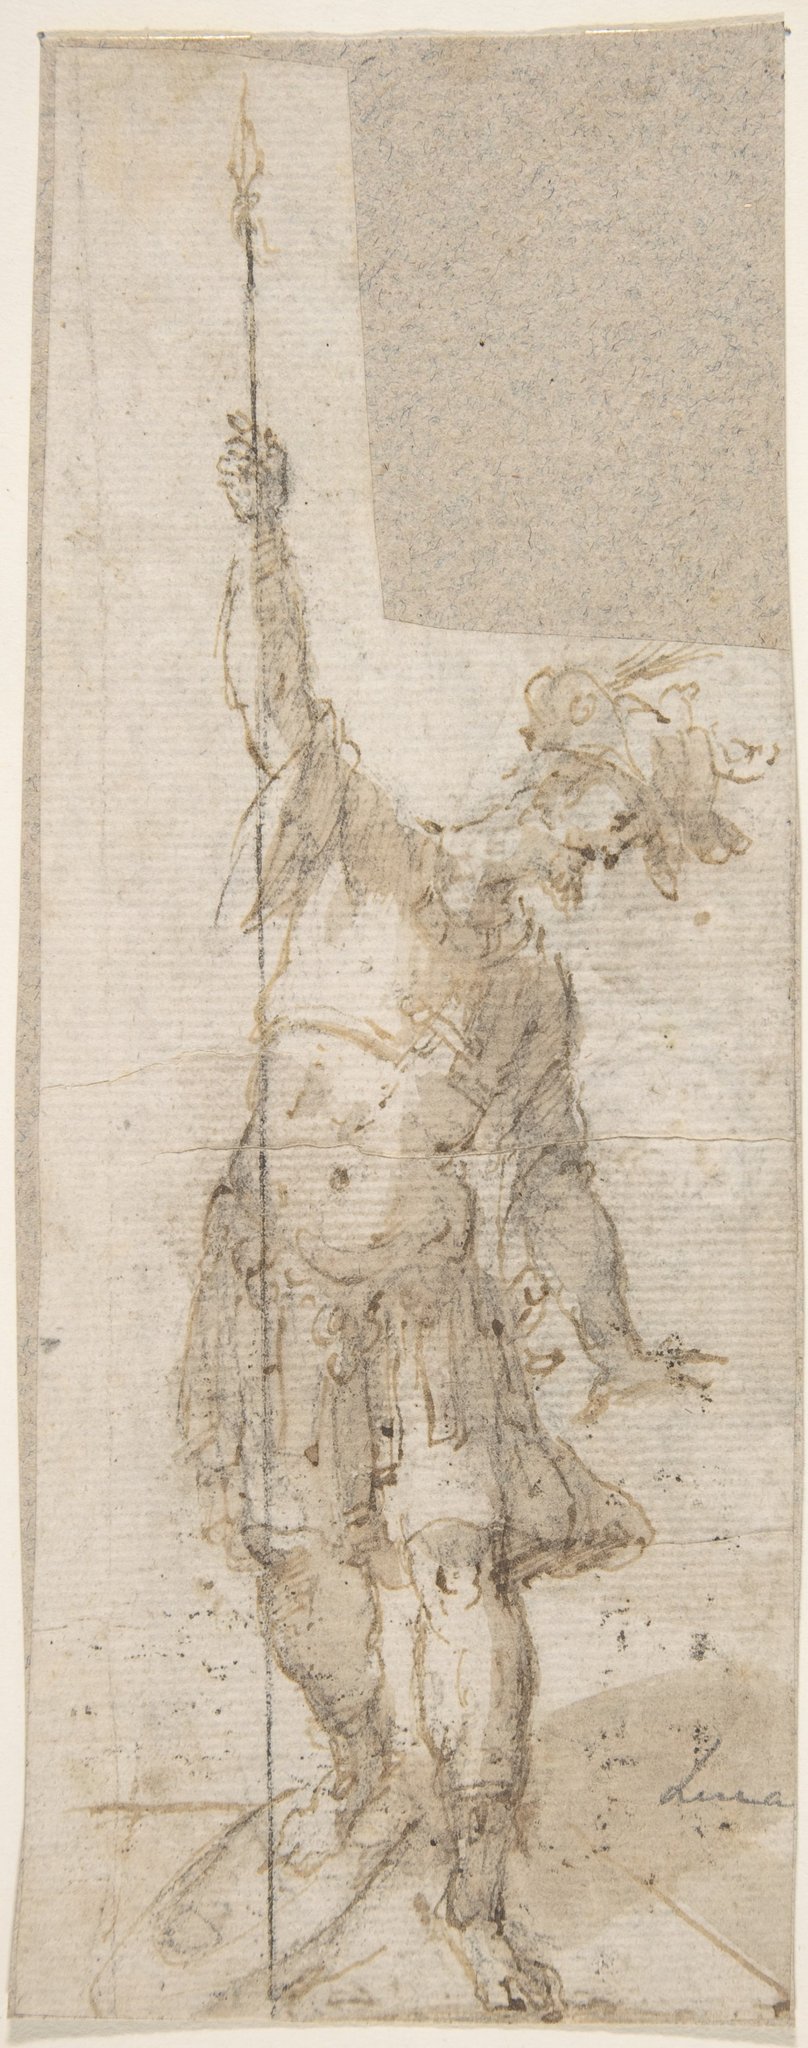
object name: drawing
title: Standing Soldier with a Spear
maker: anonymous, spanish, school of seville, 17th century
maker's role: artist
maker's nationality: spanish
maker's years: 1600-1700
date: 1601-1700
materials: chalk, ink, paper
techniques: brush, pen, wash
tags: soldiers,spears